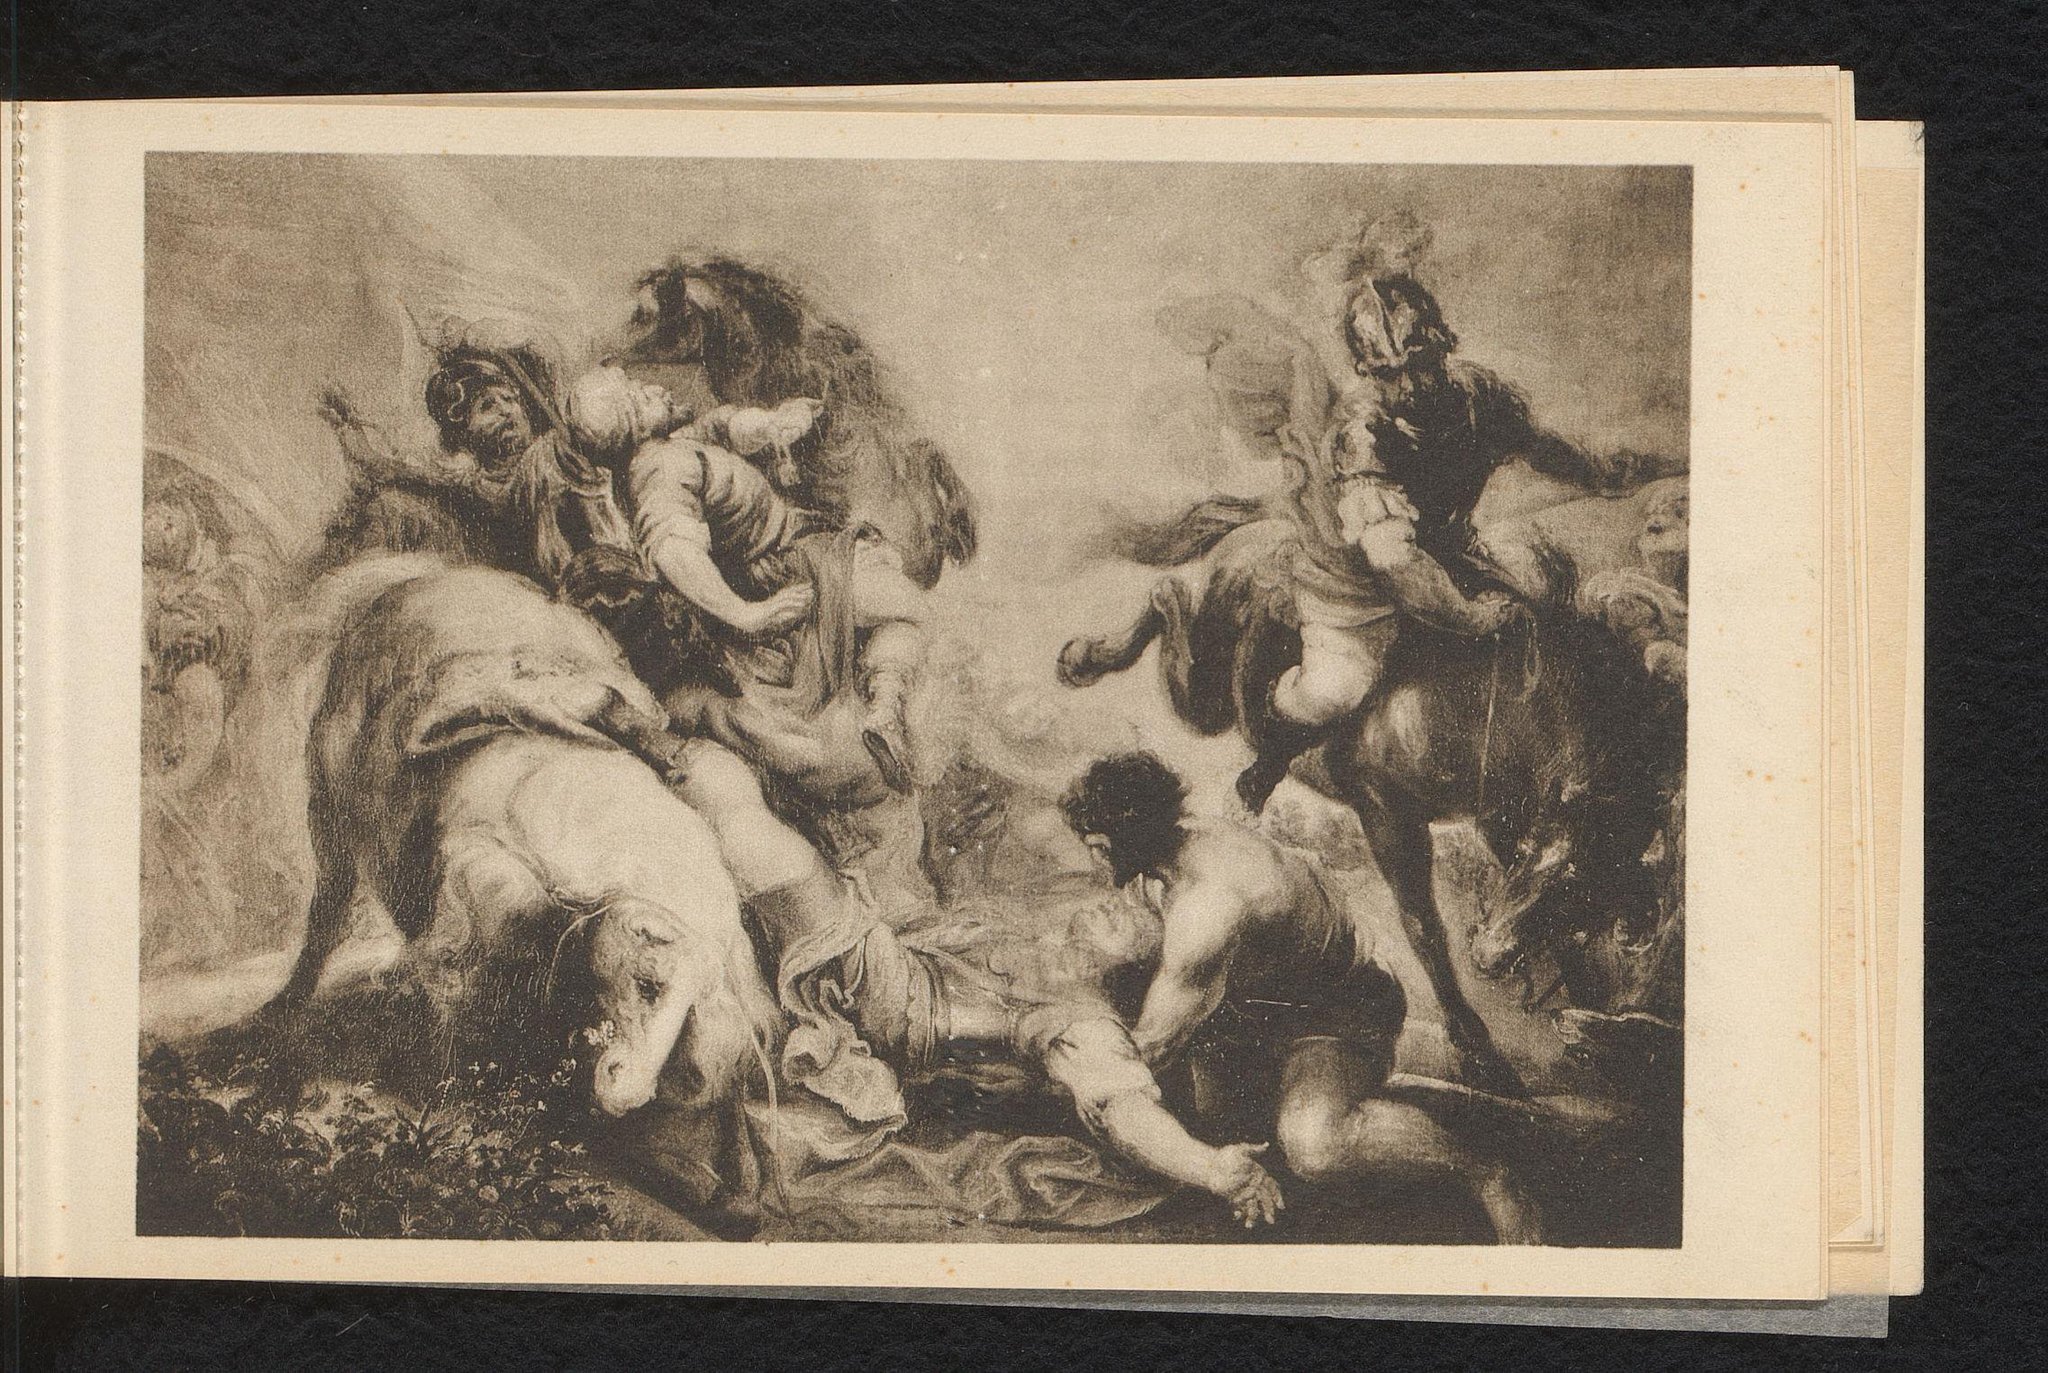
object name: reproduction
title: Museo Cerralbo. Madrid. La conversión de San Pablo. Réplica invertida de un cuadro de Rubens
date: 1924-1930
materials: cardboard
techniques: photograph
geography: madrid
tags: permanent exhibition, museum, picture, painting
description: Prentbriefkaart maakt deel uit van een album.